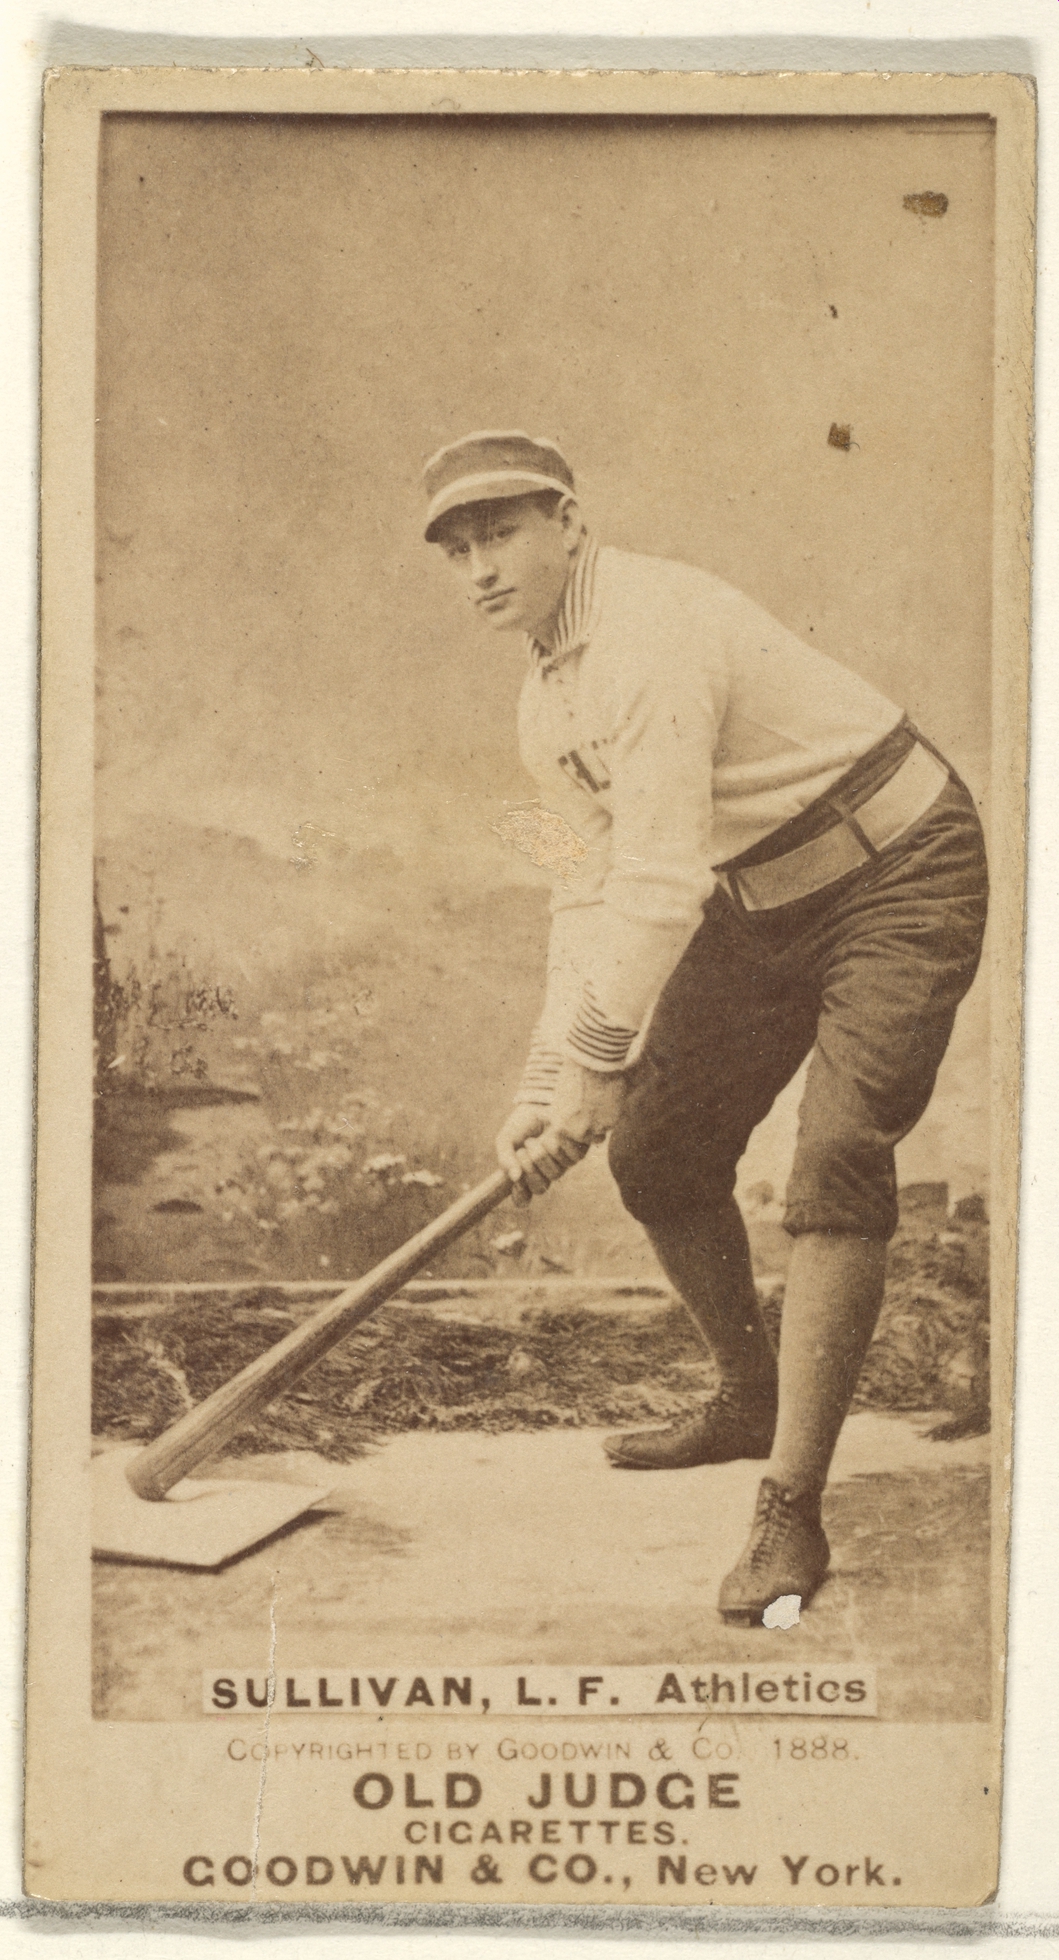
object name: baseball card, photograph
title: Sullivan, Left Field, Philadelphia Athletics, from the Old Judge series (N172) for Old Judge Cigarettes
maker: goodwin & company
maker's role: publisher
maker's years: 1850-1950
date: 1888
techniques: albumen silver print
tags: men,portraits,baseball,athletes